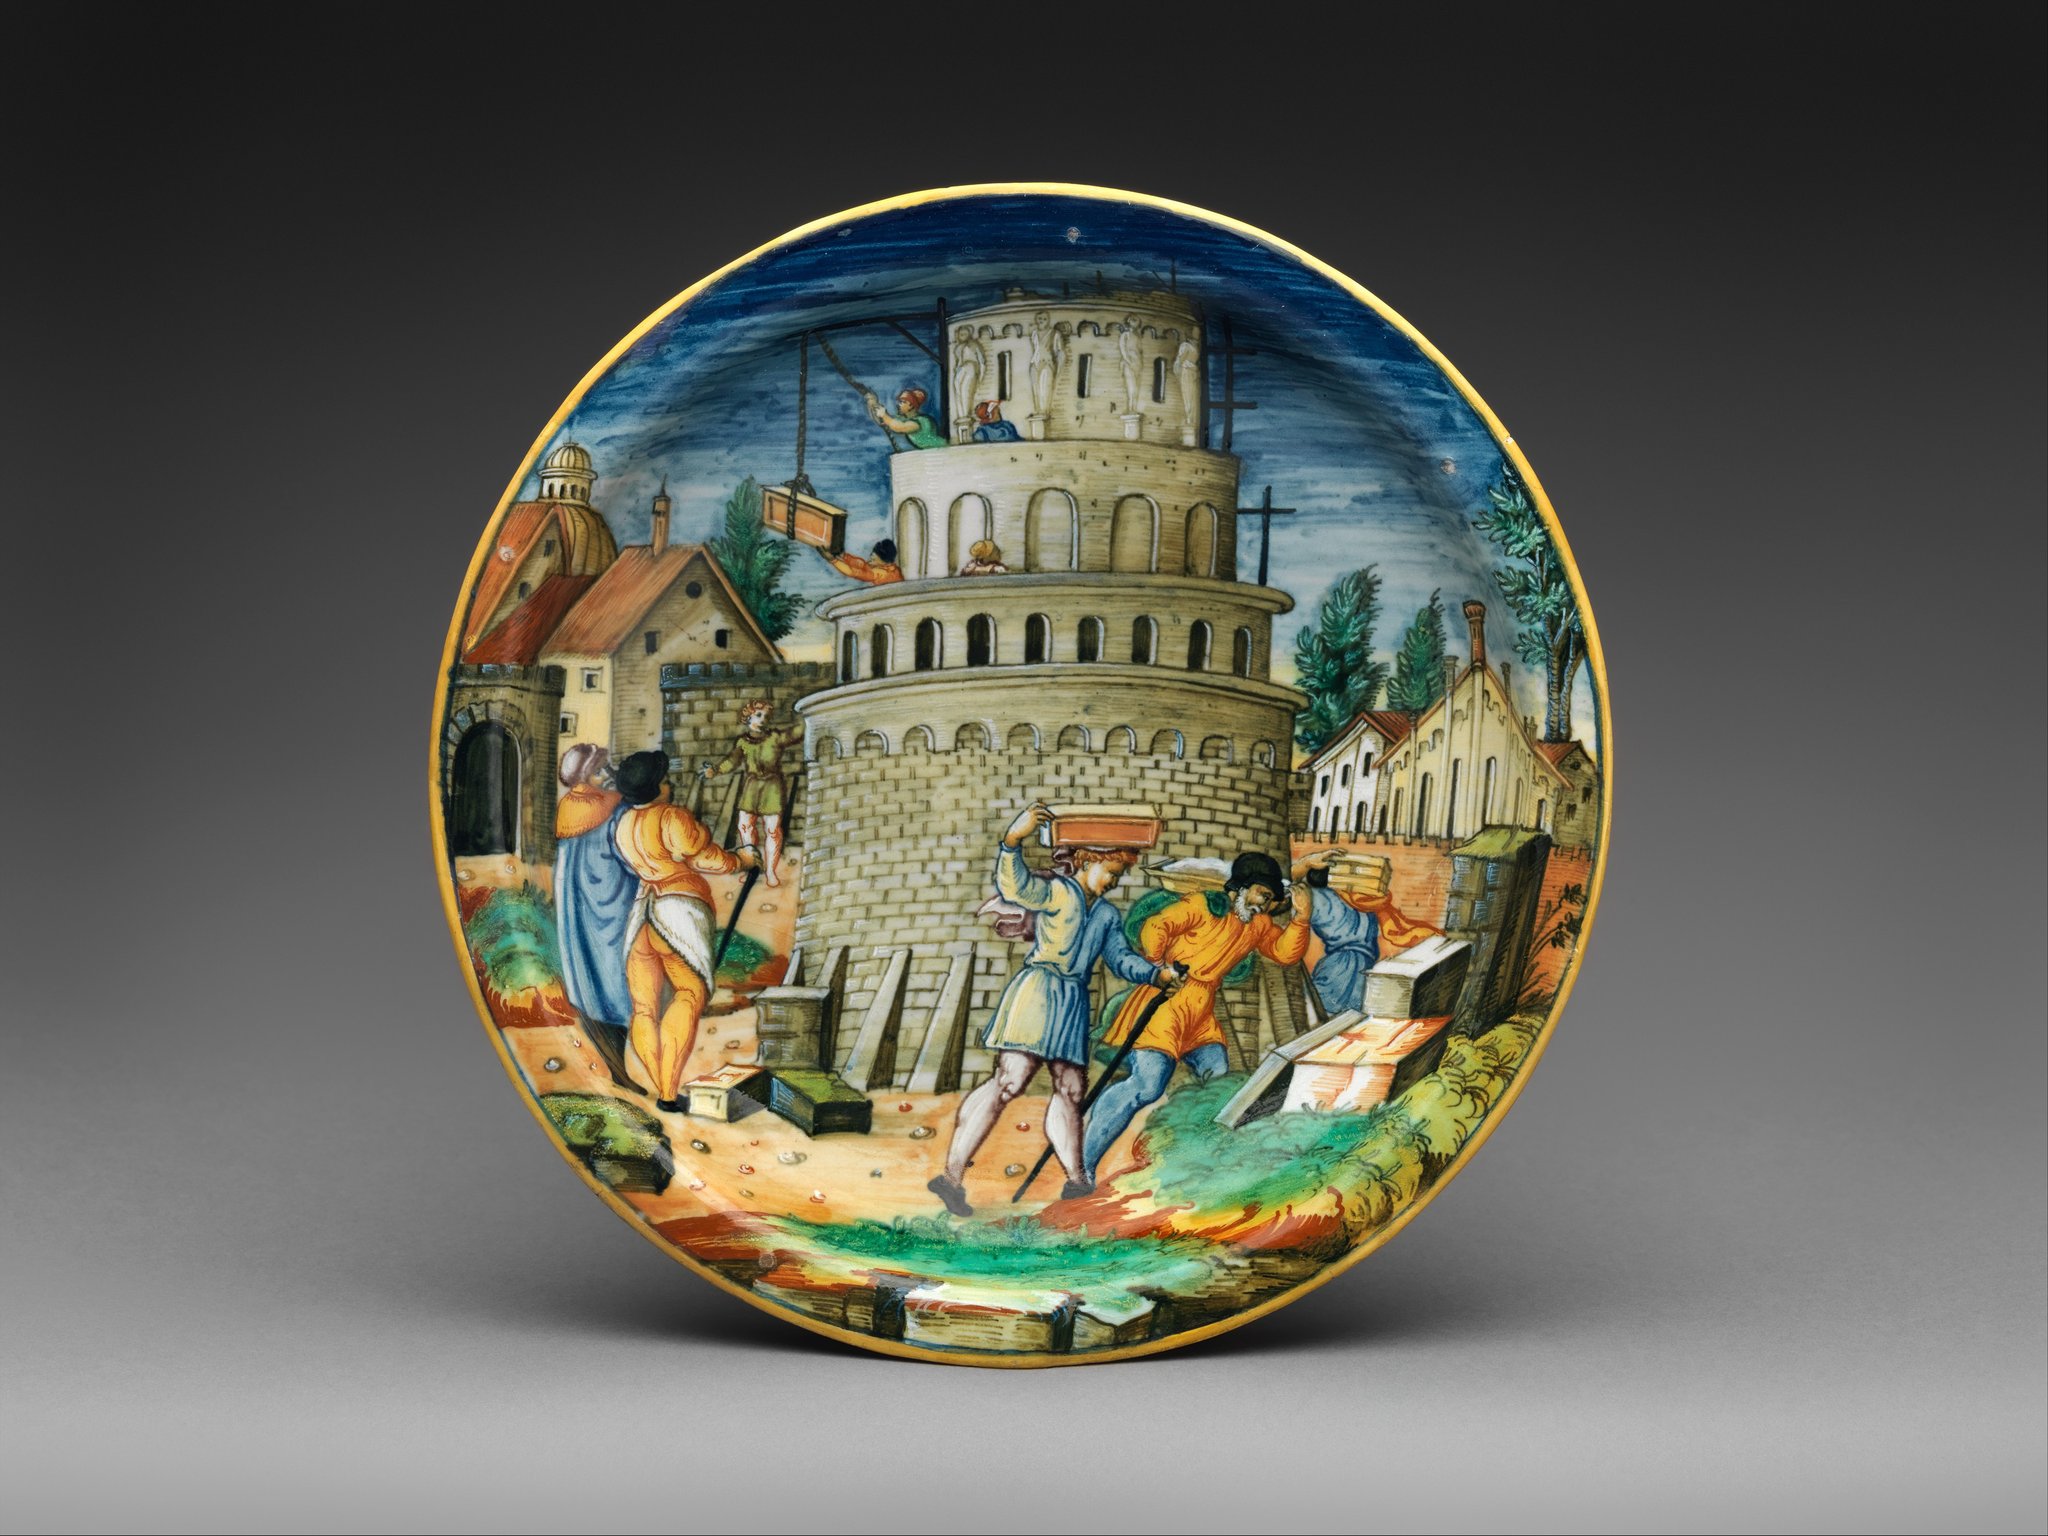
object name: plate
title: Plate with The Building of the Tower of Babel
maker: workshop of guido durantino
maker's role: artist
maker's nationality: italian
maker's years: 1516-1581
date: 1550-1560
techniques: maiolica, glazing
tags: buildings,towers,men,working